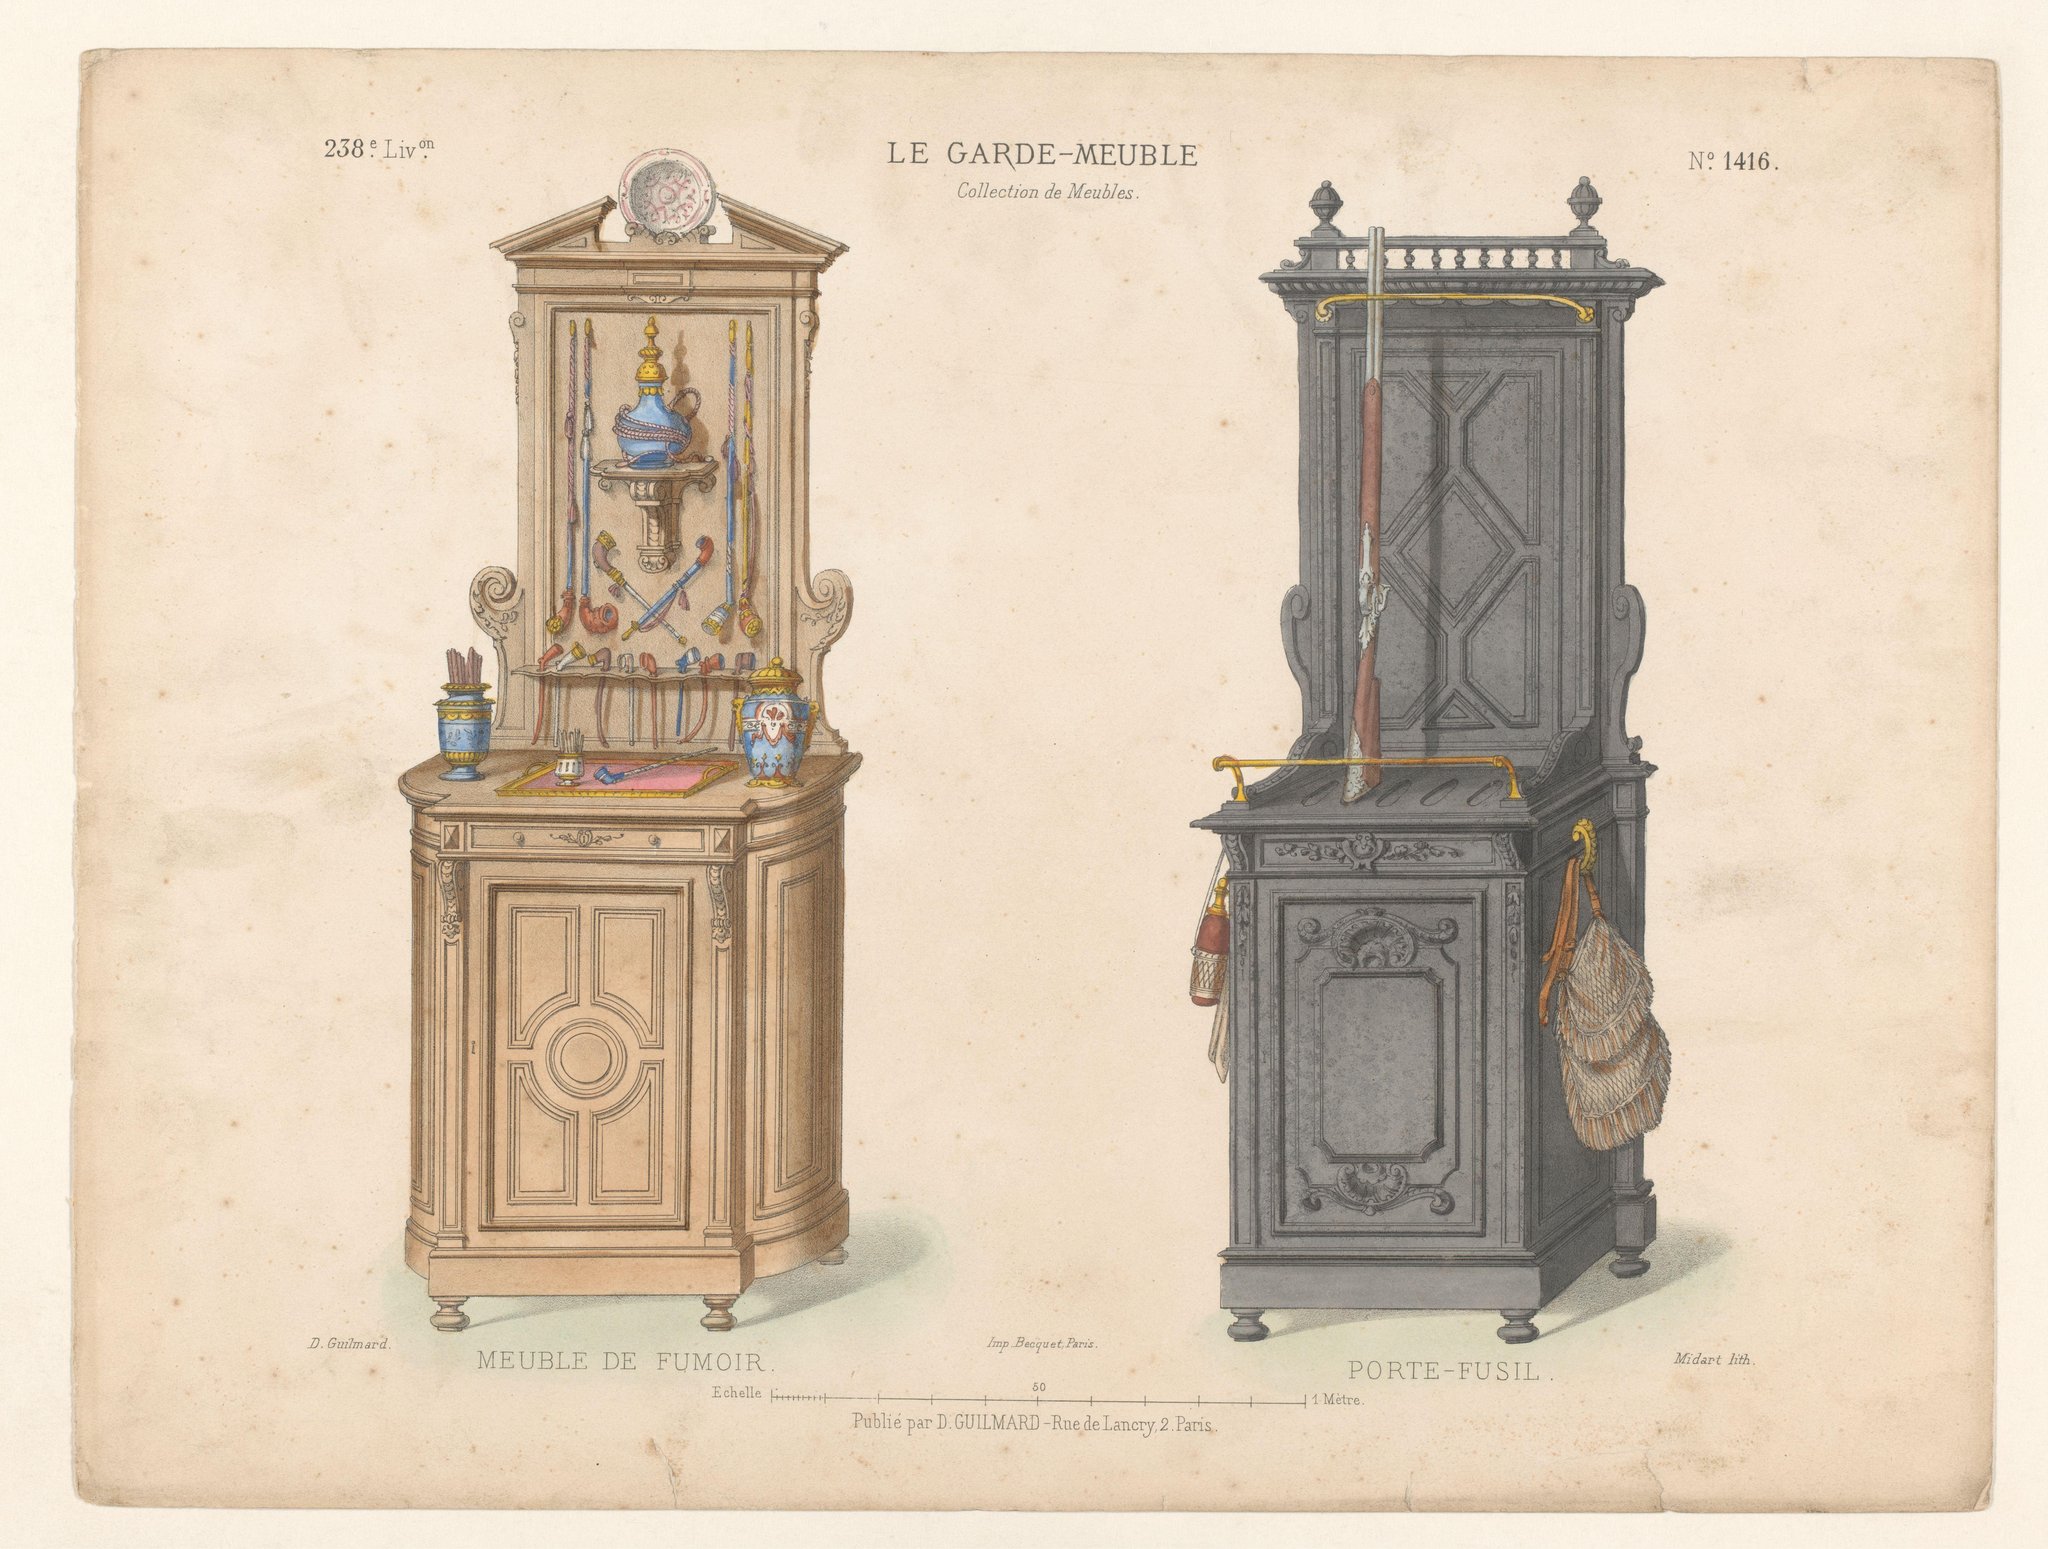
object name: print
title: Meuble de fumoir / Porte-fusil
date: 1839-1885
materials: paper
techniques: hand coloring, lithograph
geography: paris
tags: furniture for storage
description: Ieder Livraison in de serie Le Garde-Meuble bevat negen platen: drie 'sièges' (zitmeubels), drie 'meubles' (diverse meubels zoals tafels en kasten) en drie 'tentures' (gordijnen en draperieën).